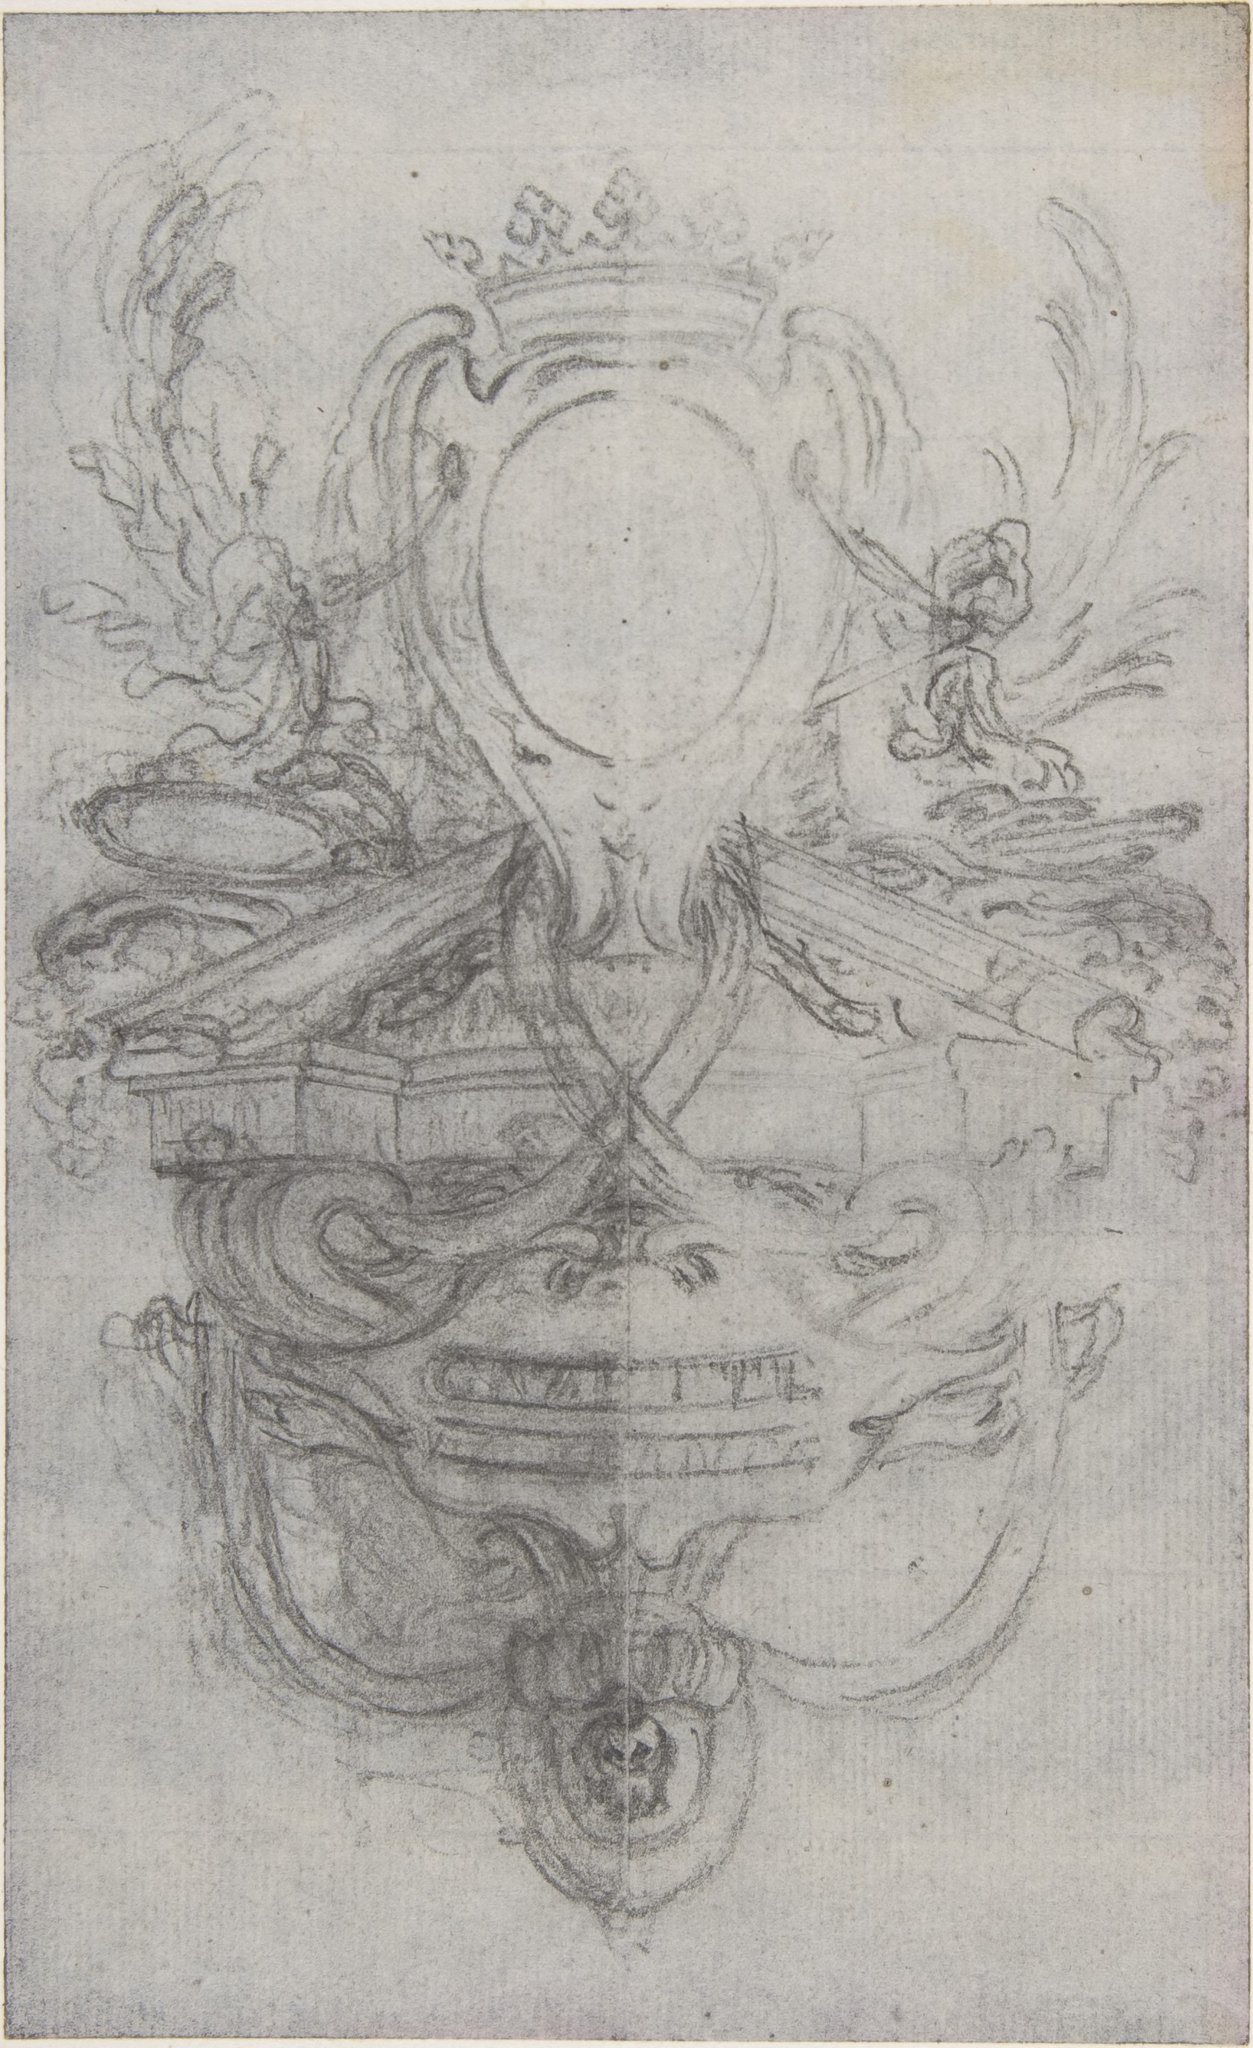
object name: drawing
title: Design for the Headpiece of the "Gazette de France"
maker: hubert françois gravelot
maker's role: artist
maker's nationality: french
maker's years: 1699-1773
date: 1701-1800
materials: chalk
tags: cartouches,coat of arms